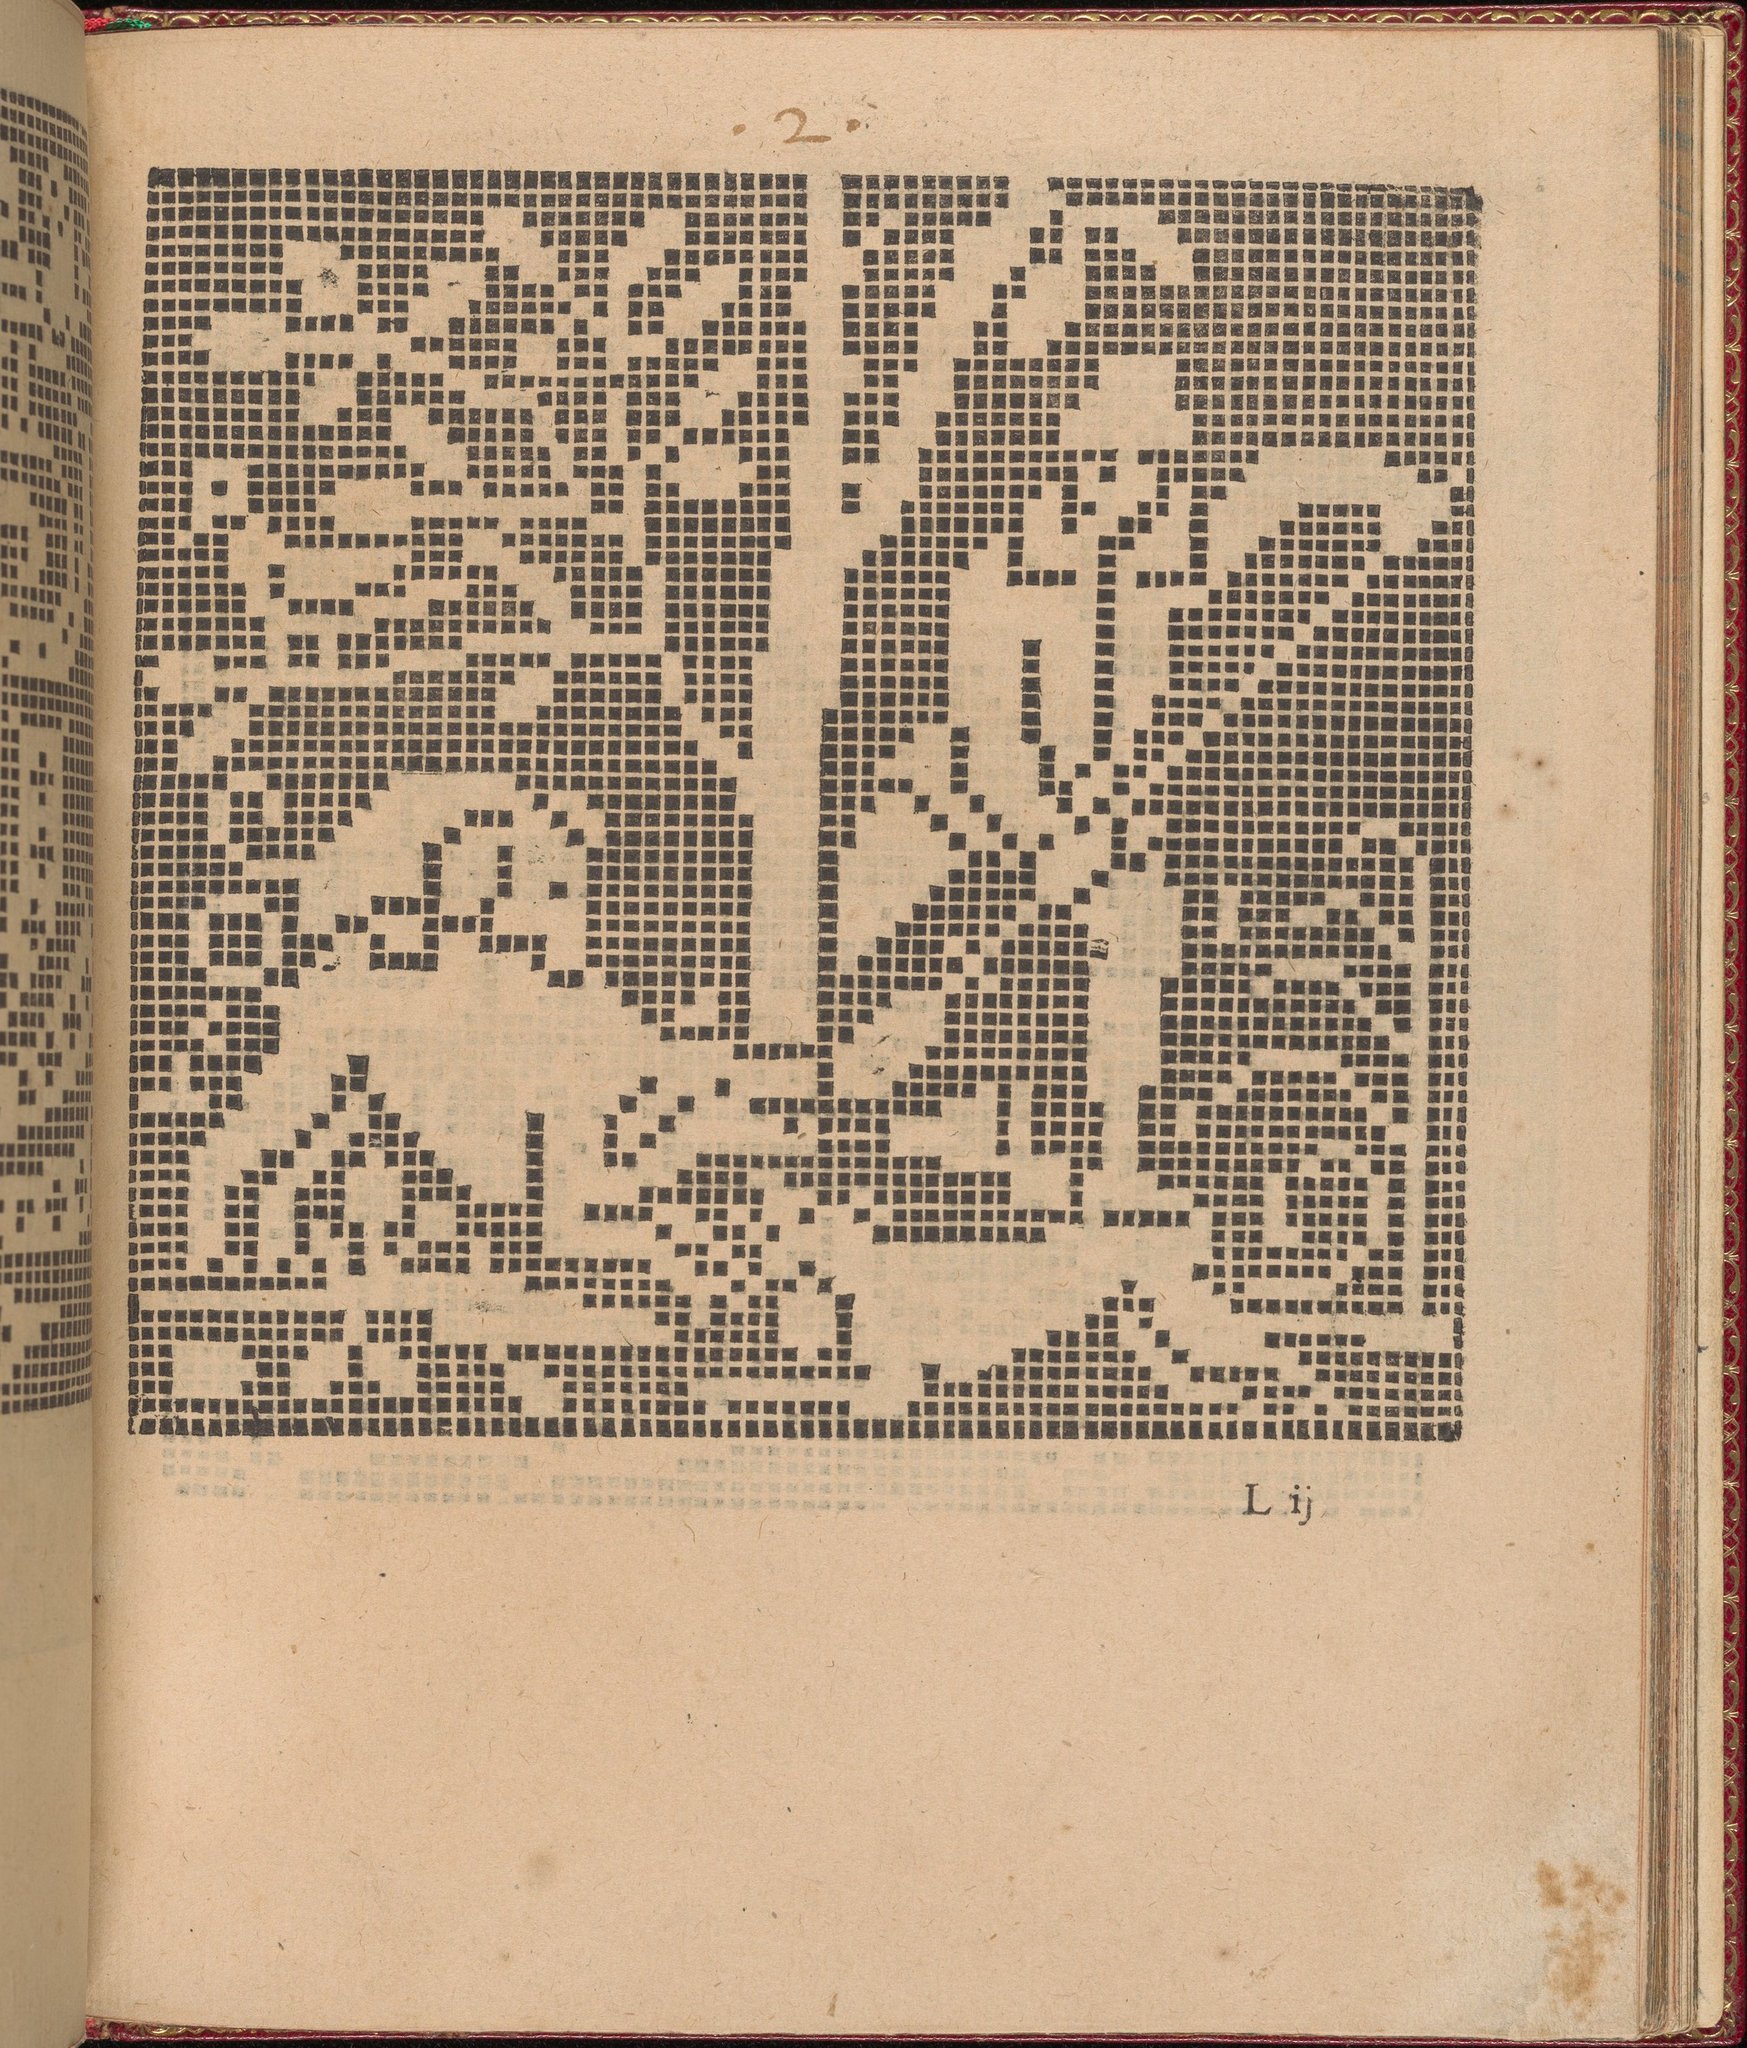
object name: book print ornament architecture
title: Les Singuliers et Nouveaux Portraicts... page 42 (recto)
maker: federico de vinciolo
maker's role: designer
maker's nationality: italian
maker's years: 1582-1599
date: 1588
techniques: woodcut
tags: birds,men,hunting,dogs,trees